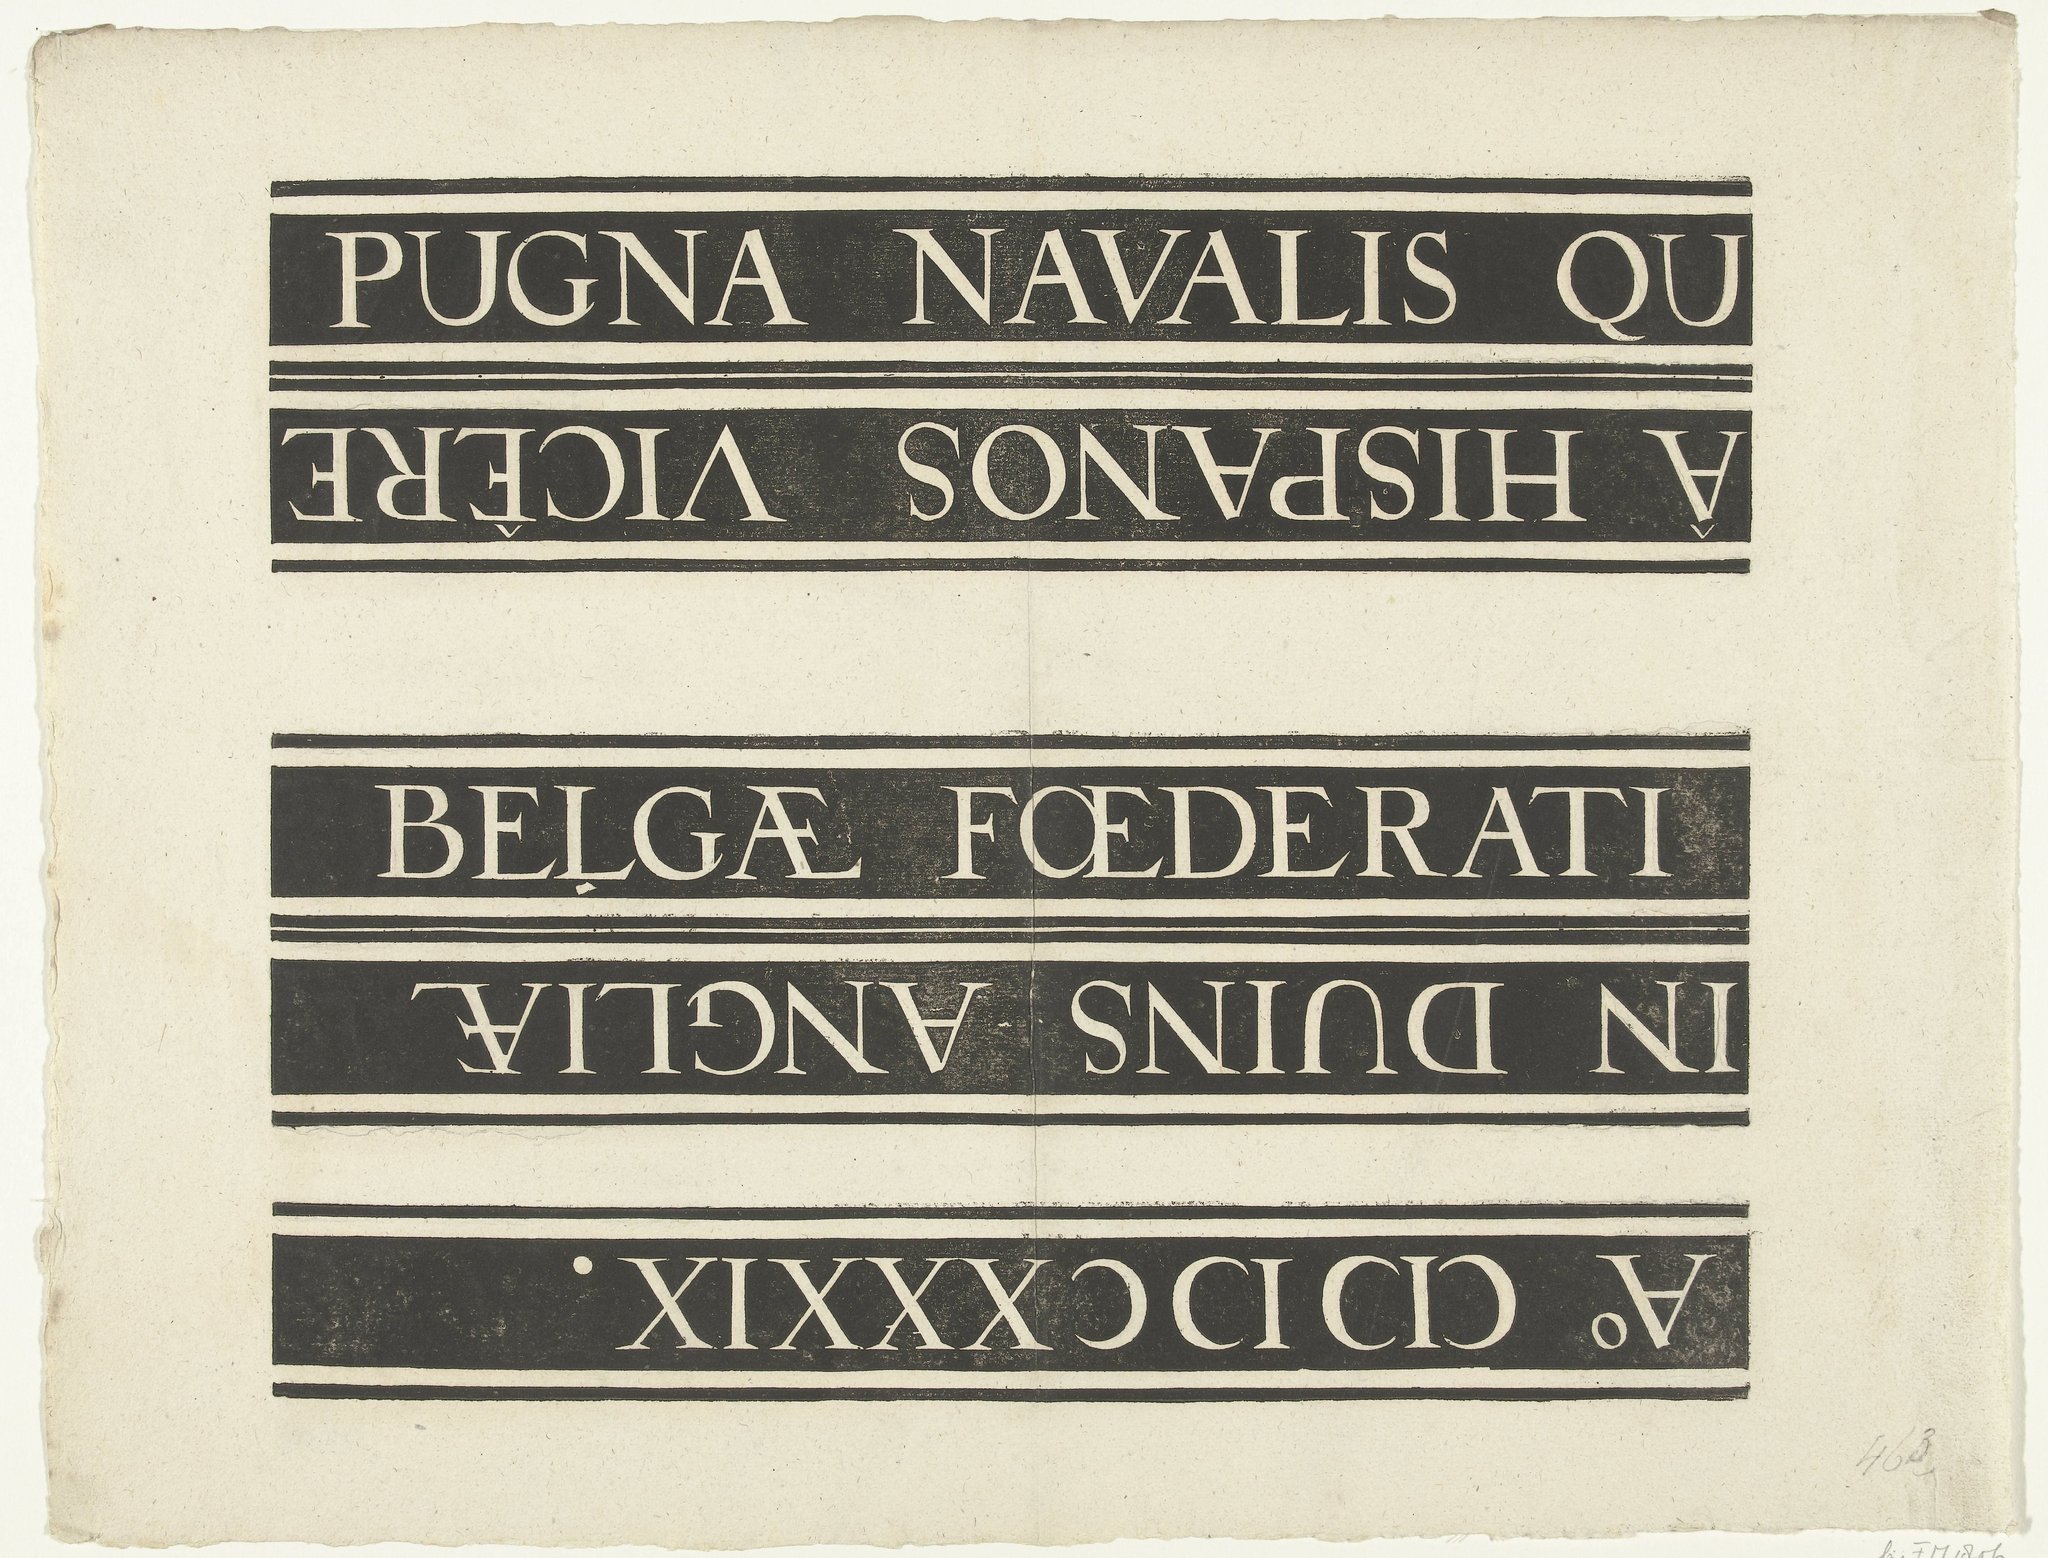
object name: print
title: Pugna navalis qua Hispanos vicere in Duins Angliae Belgae Foederati Ao. MDCXXXIX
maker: claes jansz. visscher (ii)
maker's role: draughtsman, print maker, publisher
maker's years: 1586-1652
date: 1640-1643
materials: paper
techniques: woodcut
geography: amsterdam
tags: brielle, maarten harpertszoon tromp, battle of the downs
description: Grote voorstelling van de zeeslag bij Duins tussen de Spaanse vloot onder bevel van Antonio de Oquendo en de Staatse vloot onder Maarten Harpertsz. Tromp, 21 oktober 1639. Onversneden blad met de titel in 5 delen onder elkaar gedrukt. Ongemonteerde ensemble bestaande uit 7 genummerde platen, de zwarte stroken met de titel en tekstblad met de beschrijving.